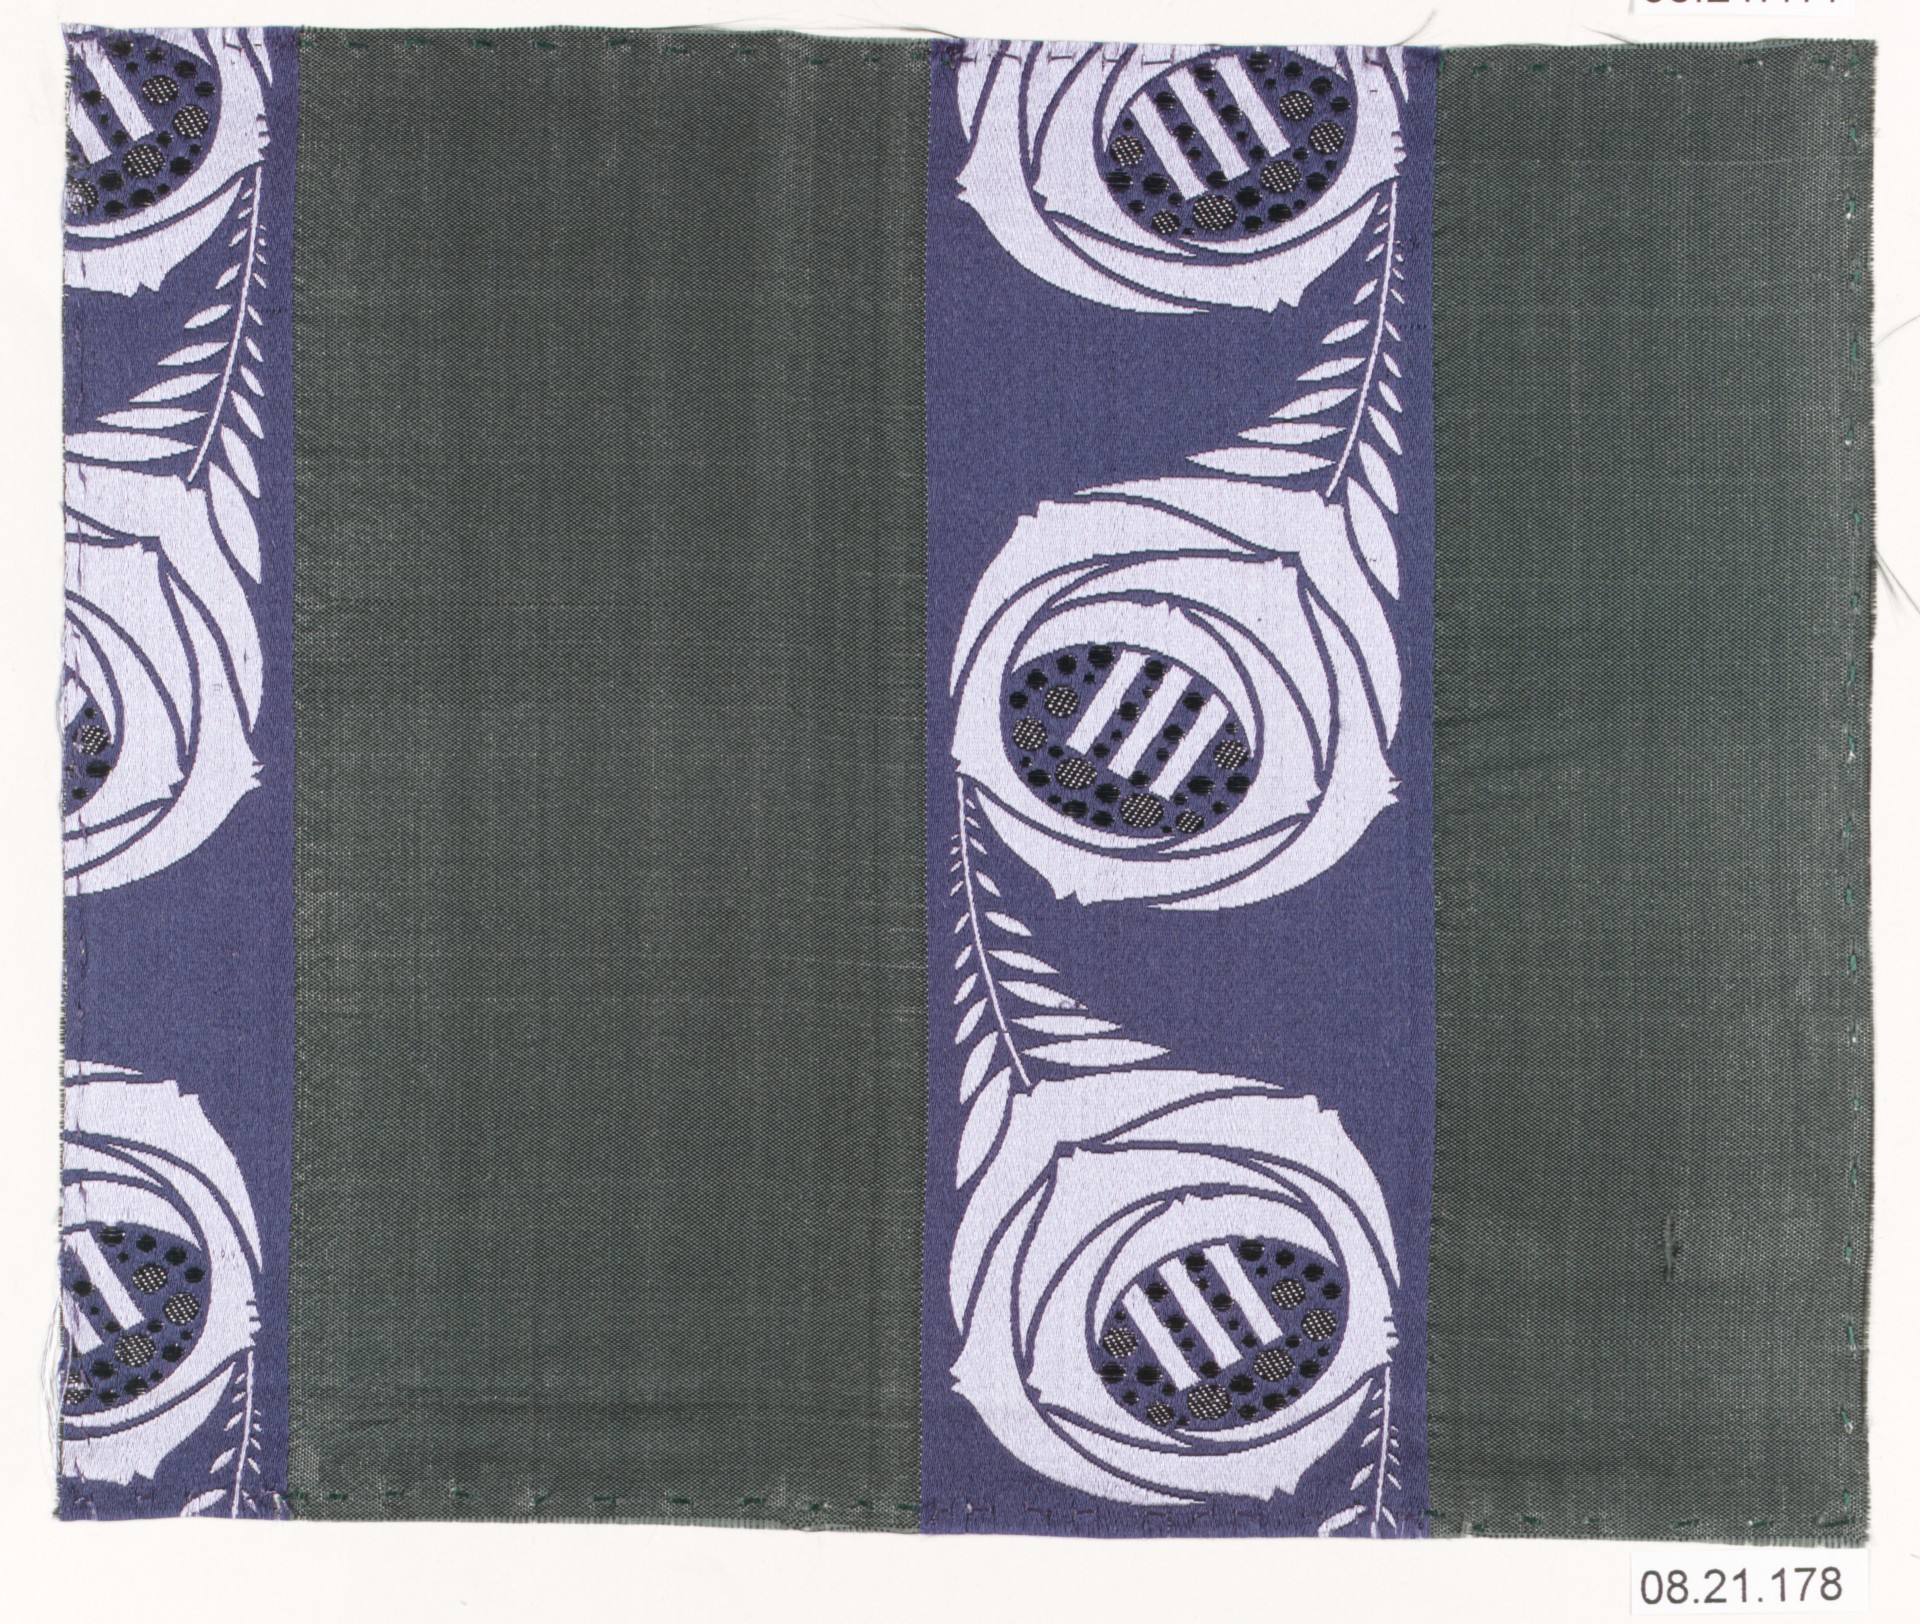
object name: textile sample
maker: Anonymous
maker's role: designer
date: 1900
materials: silk